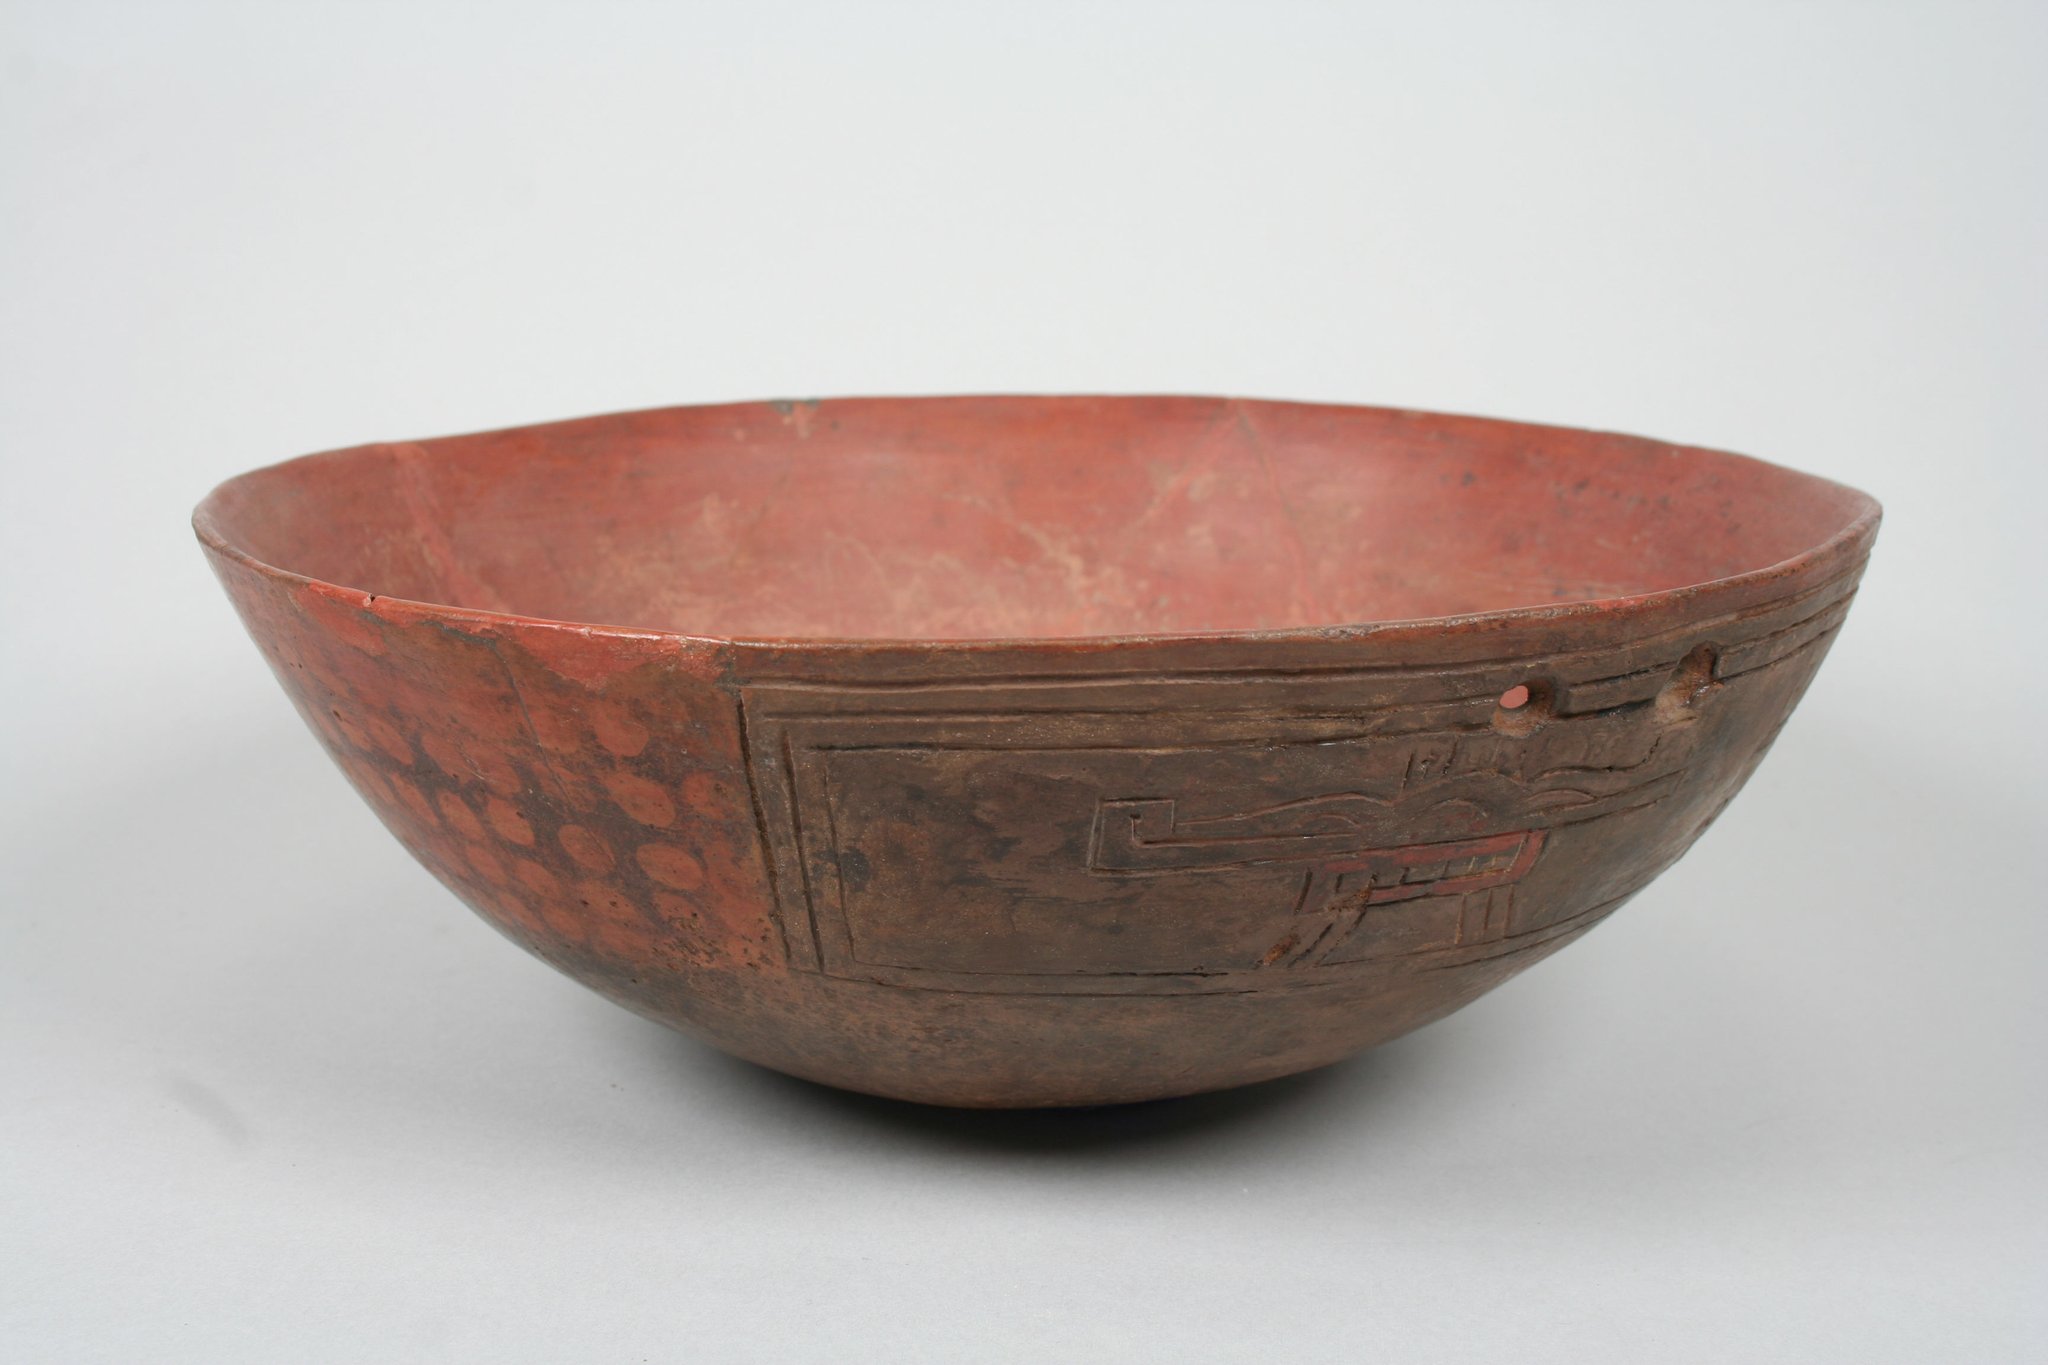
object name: bowl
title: Incised bowl with felines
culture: paracas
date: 500-201 BCE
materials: ceramic, pigment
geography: peru